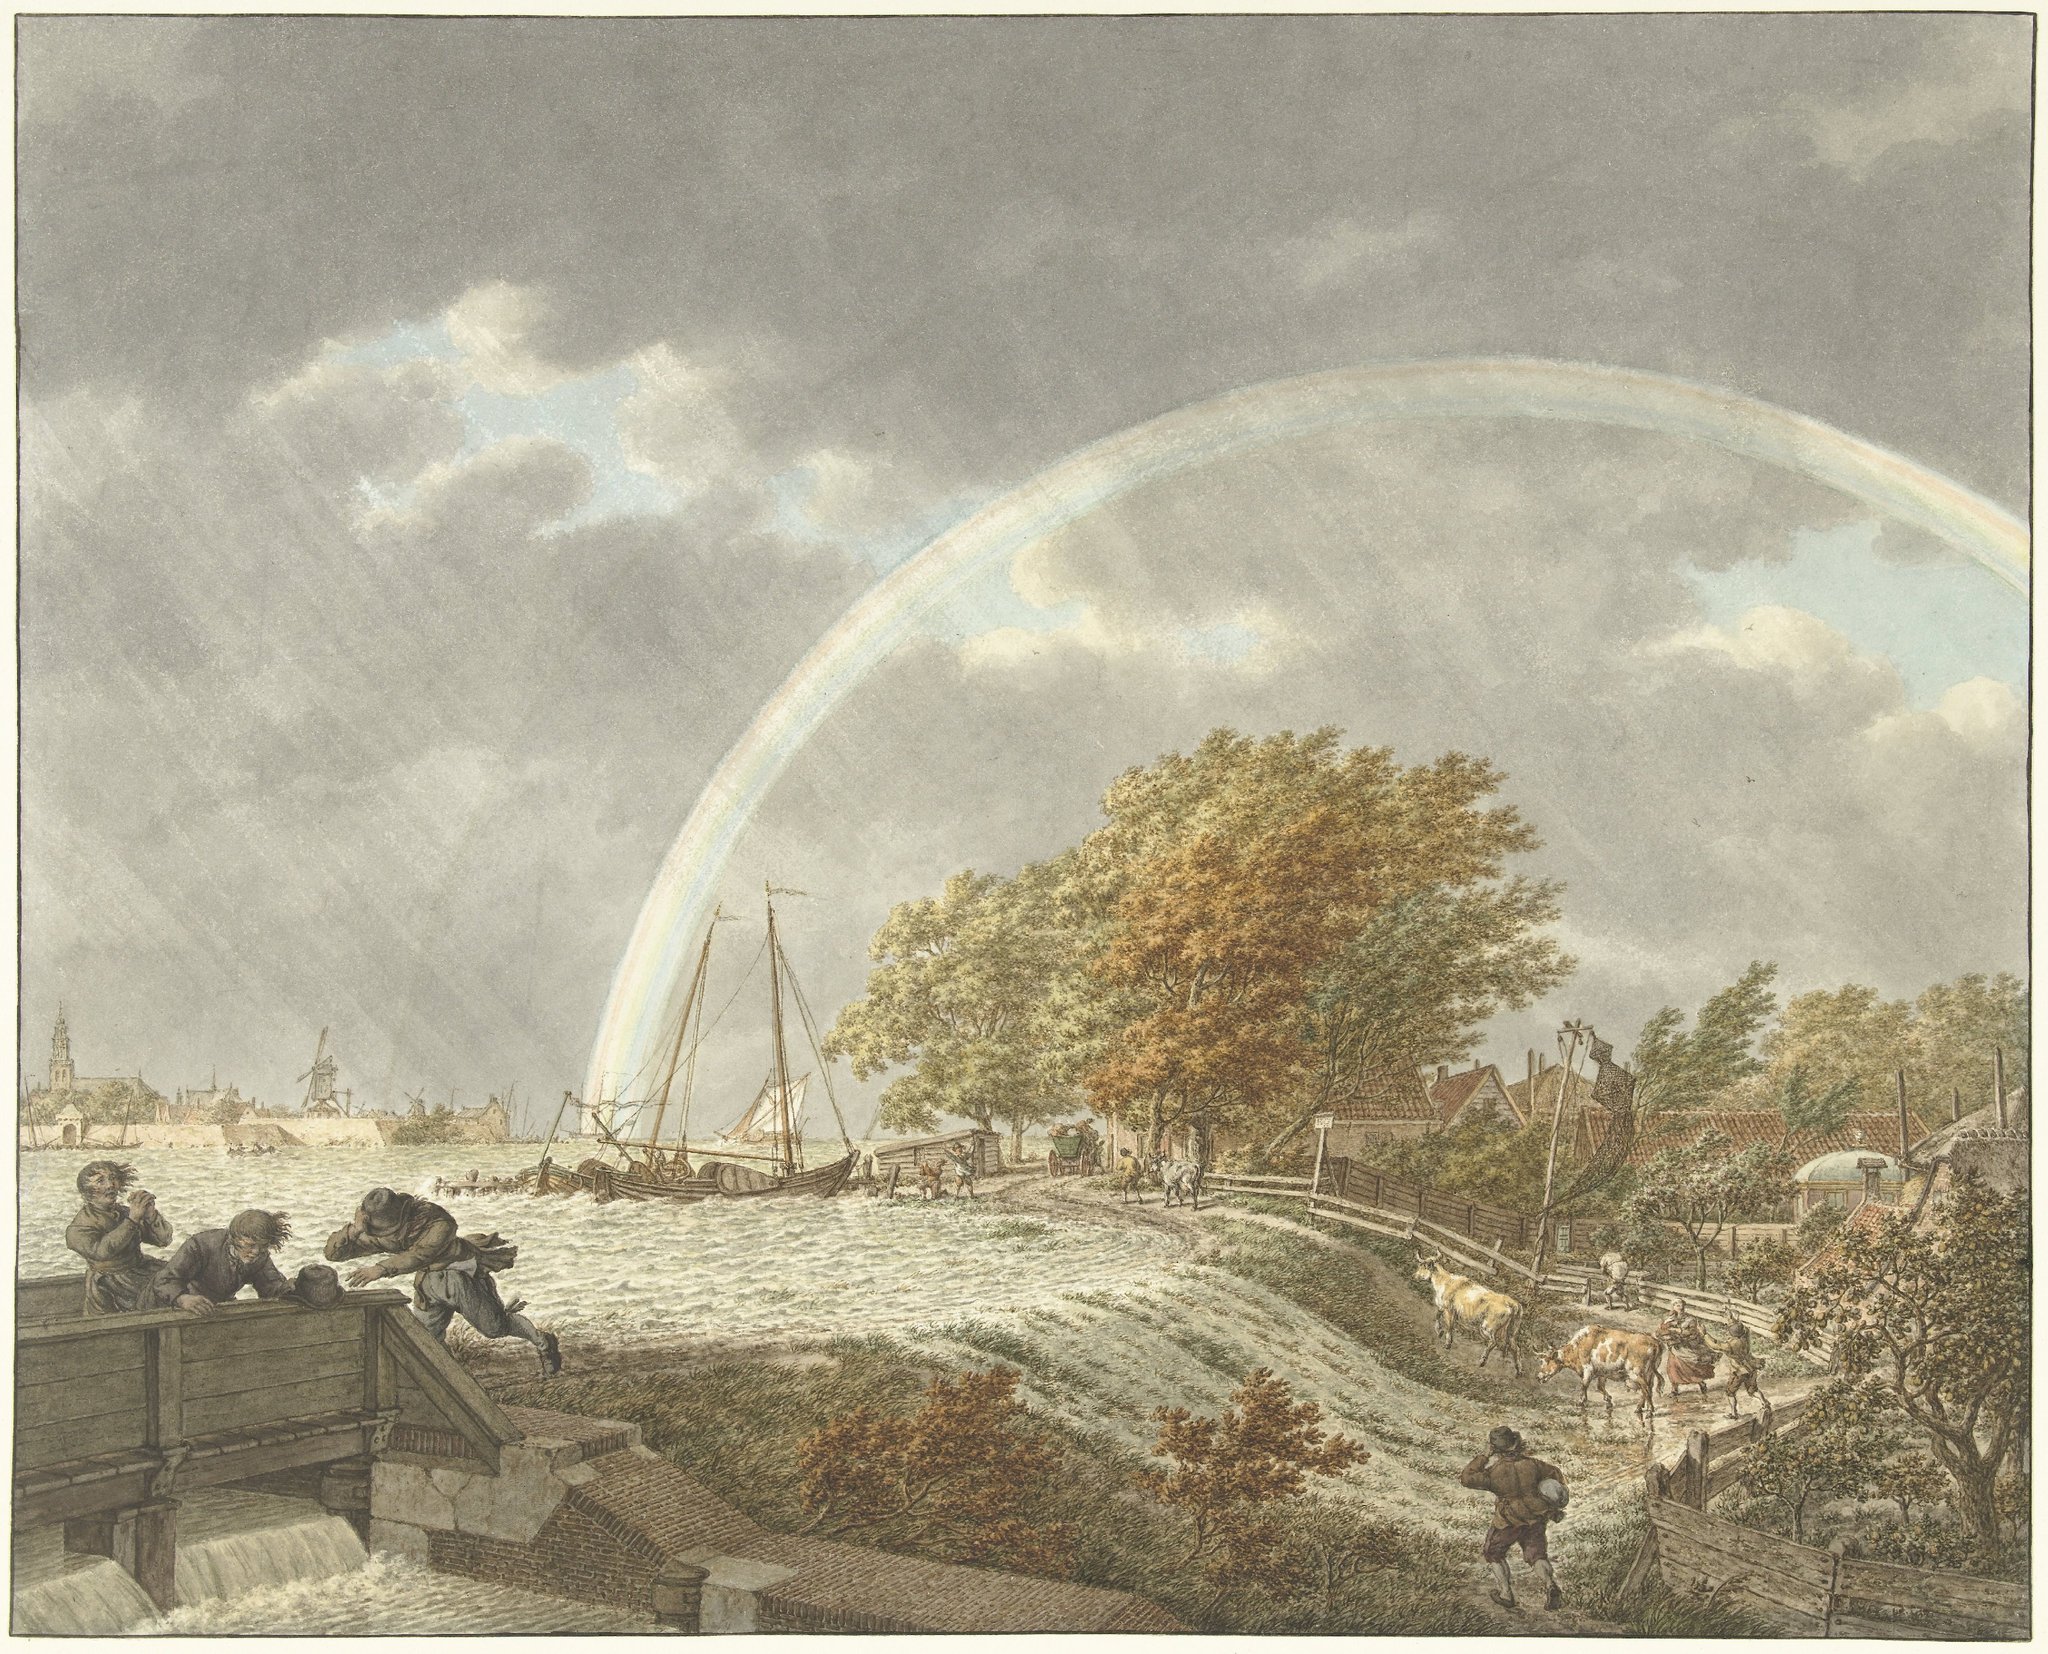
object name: drawing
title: Spring, Morning and Earth Summer, Afternoon and Air Autumn, Evening and Water Winter, Night and Fire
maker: jacob cats (1741-1799)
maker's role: draughtsman, print maker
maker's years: 1741-1799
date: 1797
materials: ink, paper, watercolor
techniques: brush, pen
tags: water (one of the four elements), evening, autumn landscape; landscape symbolizing autumn (the four seasons of the year)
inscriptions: signature and date: ‘J: Cats fec 1797’, inscription: ‘September, October, November / Herfst Namiddag Waater. / J: Cats fec 1797’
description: Series of landscapes with the Four Seasons as their theme were not exceptional in the 18th century. In these drawings, however, Jacob Cats did something unusual. He linked them to the Four Times of the Day and the Four Elements. These added dimensions manifest themselves in the smallest of details, such as the pale morning light in the drawing depicting the Spring, Morning and Earth.